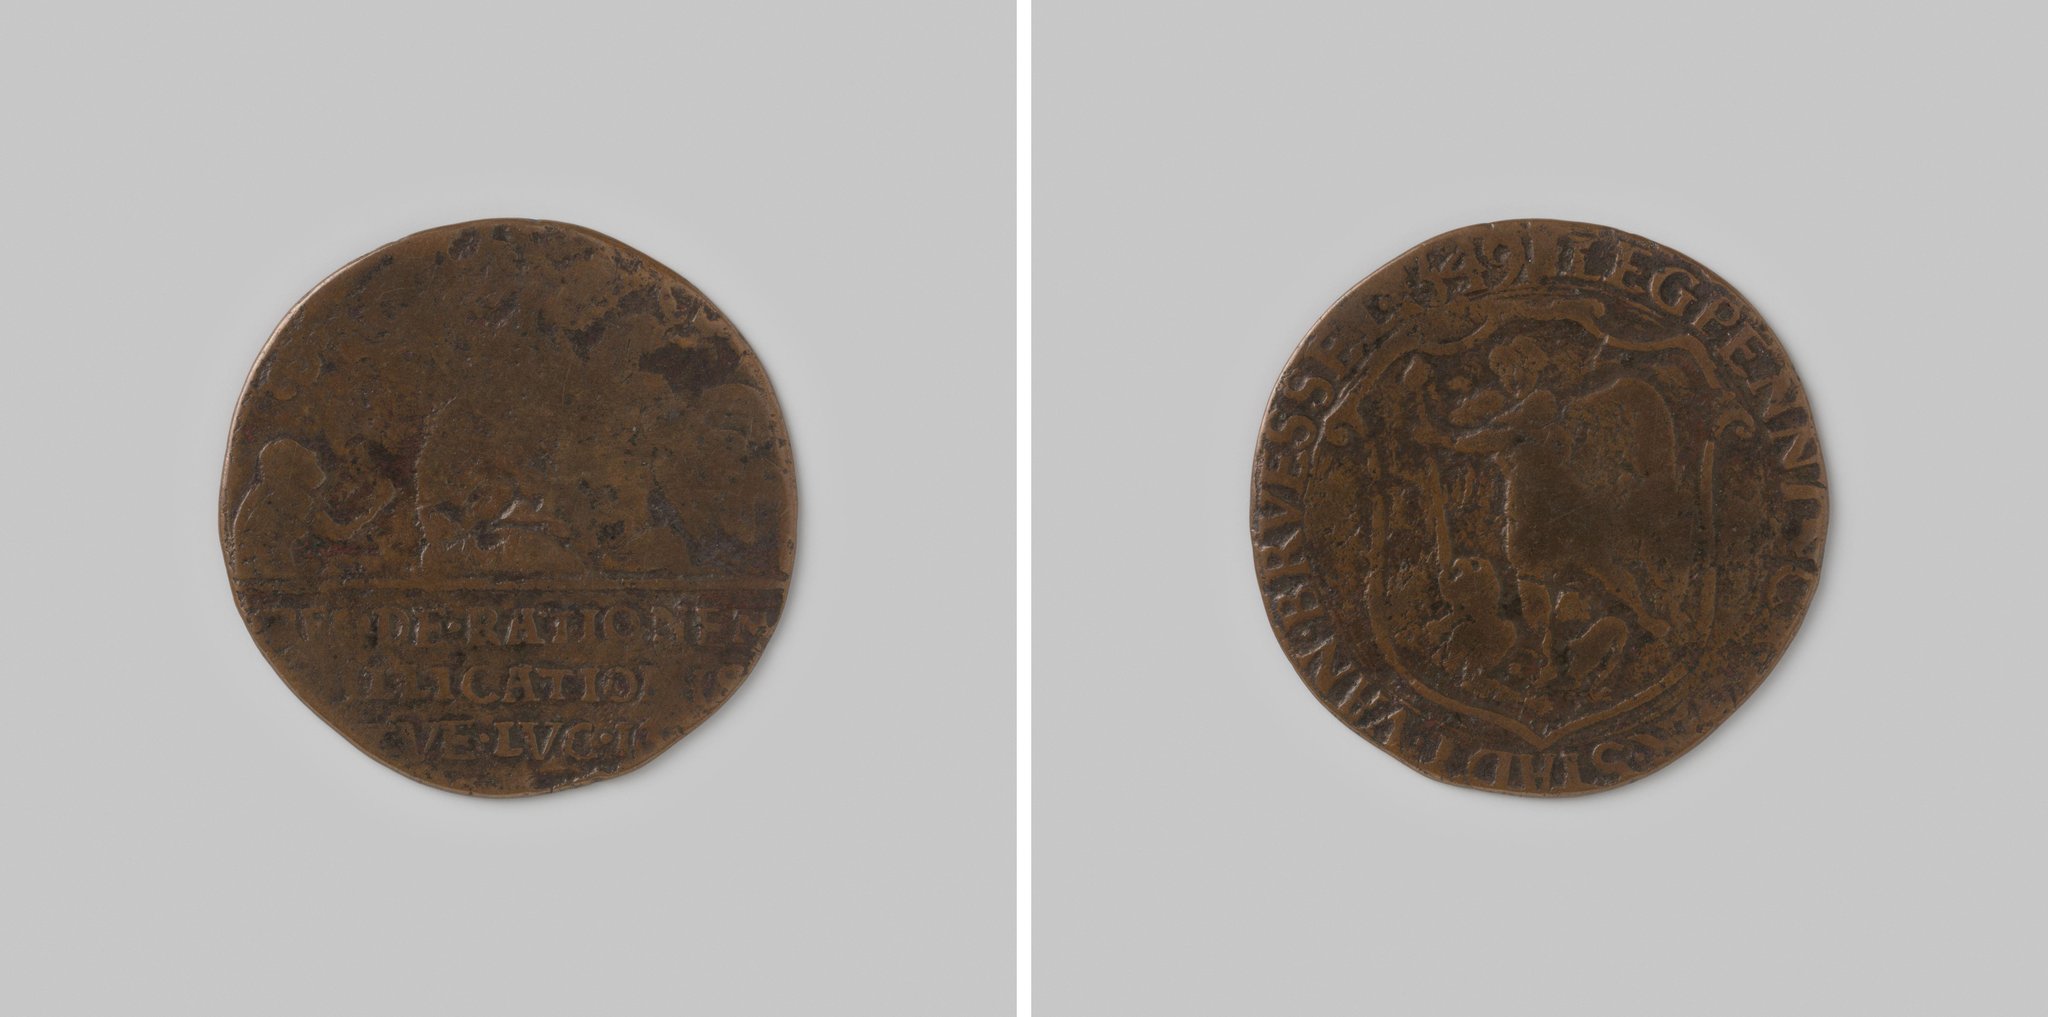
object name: jeton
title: Rekenpenning uit Antwerpen voor de stad Brussel op het overlijden van Paus Paulus III 1549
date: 1549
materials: copper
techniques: striking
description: Koperen penning, op de voorzijde het laatste oordeel met afsnedetekst, op de keerzijde het wapenschild van Brussel met omschrift.